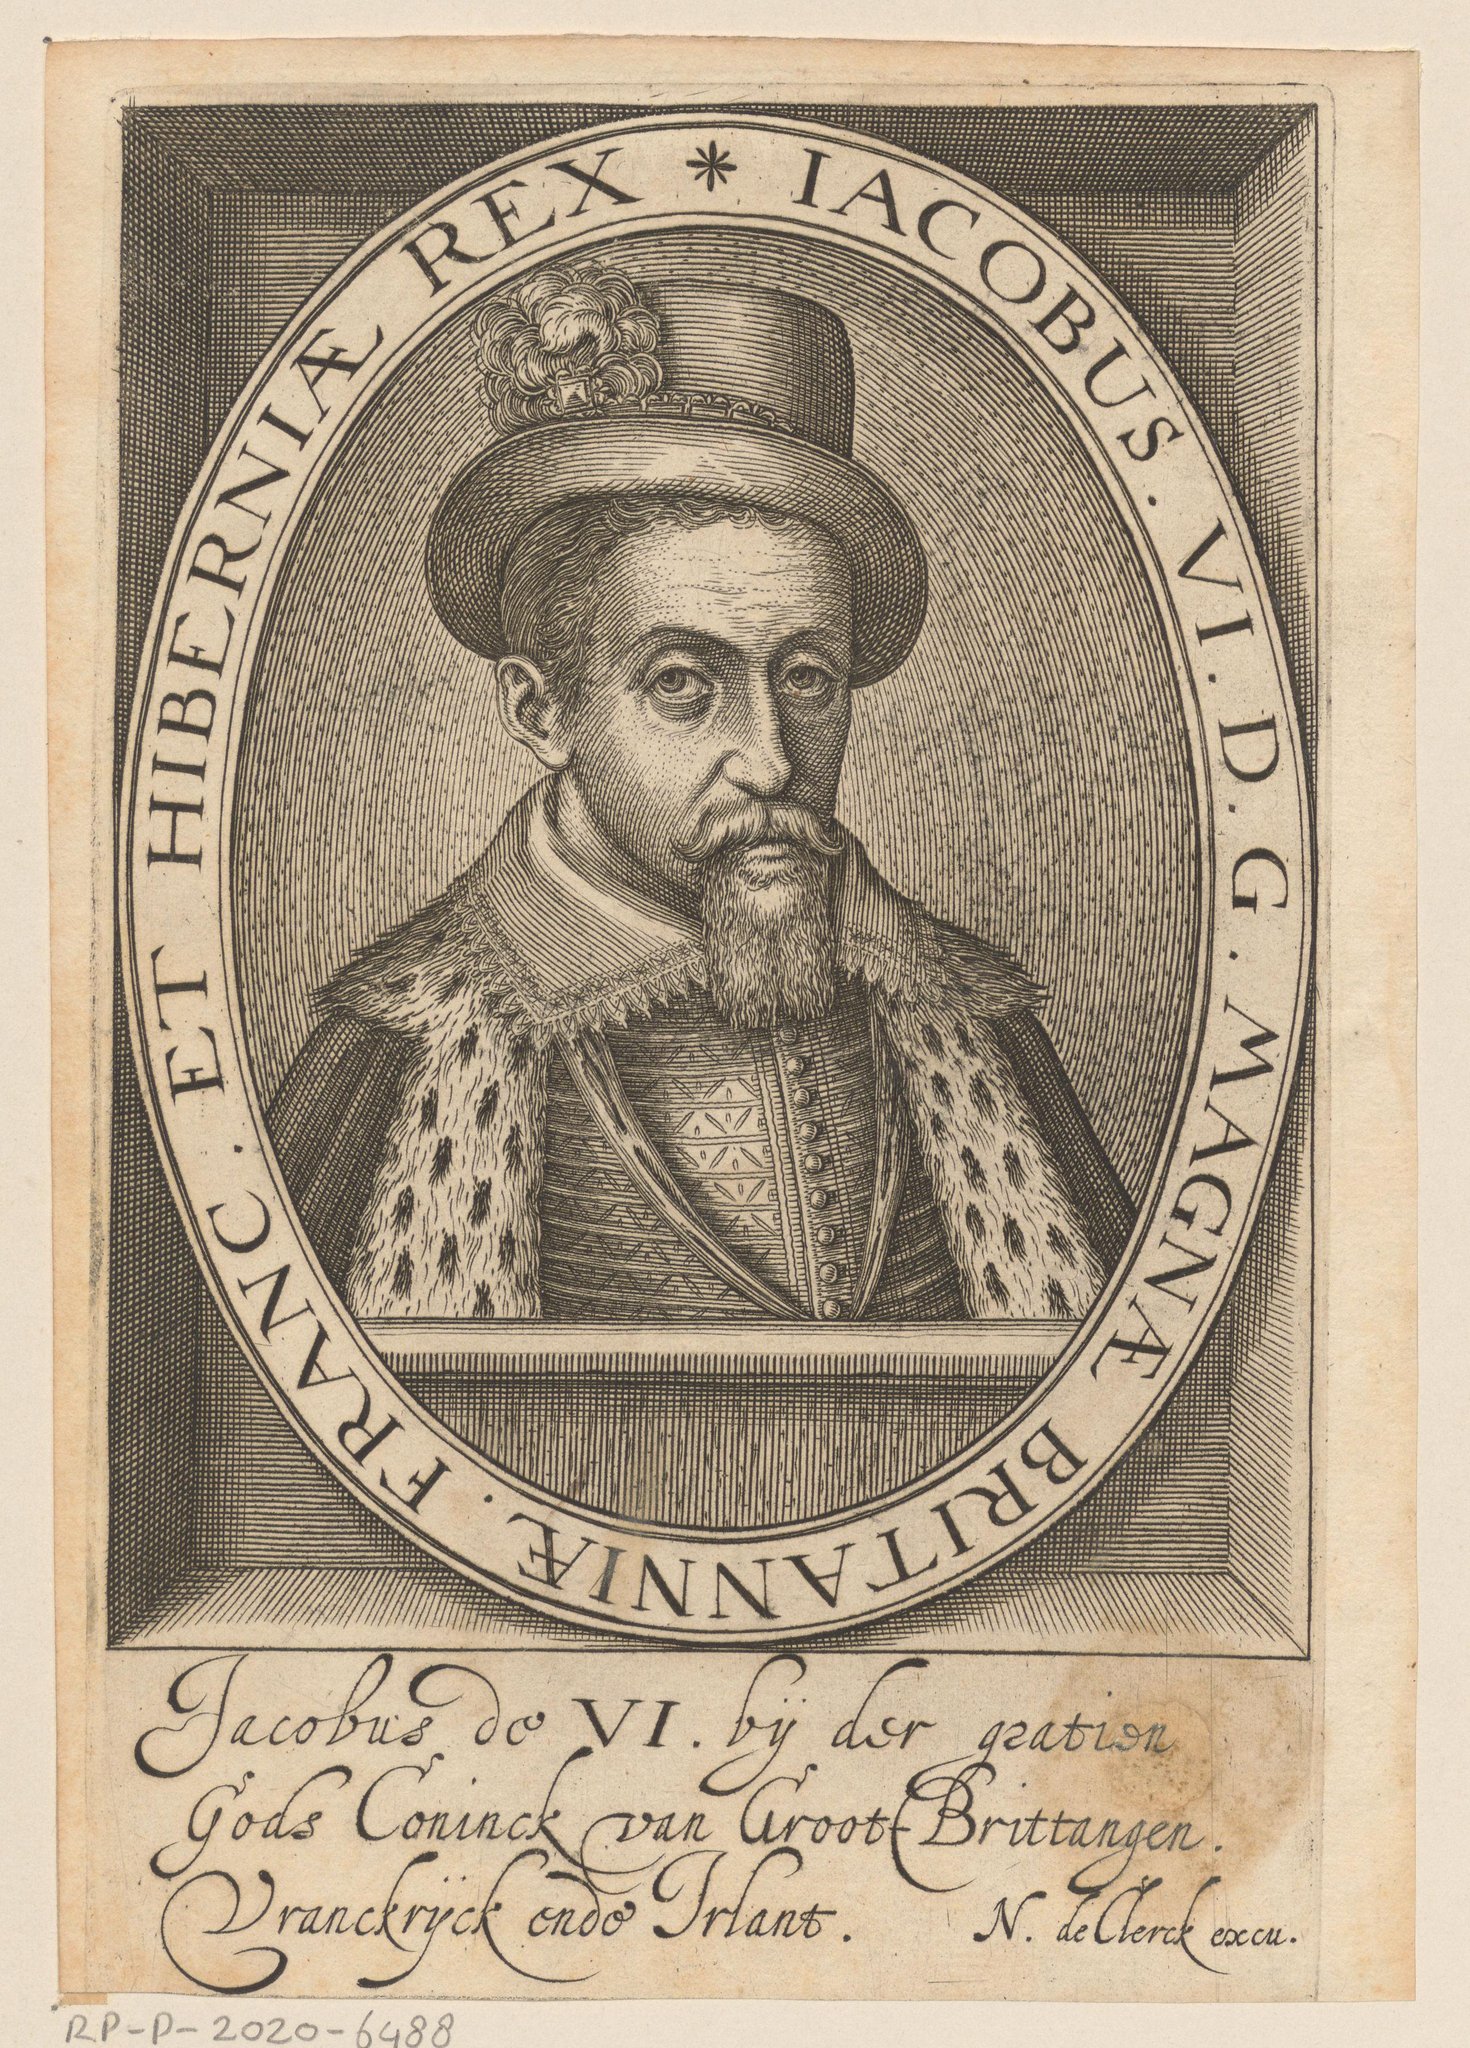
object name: print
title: Portret van Jacobus I, koning van Engeland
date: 1615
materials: paper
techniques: engraving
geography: delft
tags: jacobus i (koning van engeland), historical persons, king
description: Prent met tekst in boekdruk op verso gebruikt in: Clerck, Nicolaes de. Tooneel der keyseren en coningen van Christenryck sedert den onderganck van het Griecks keyserdom. Delft: Nicolaes de Clerck, 1615.